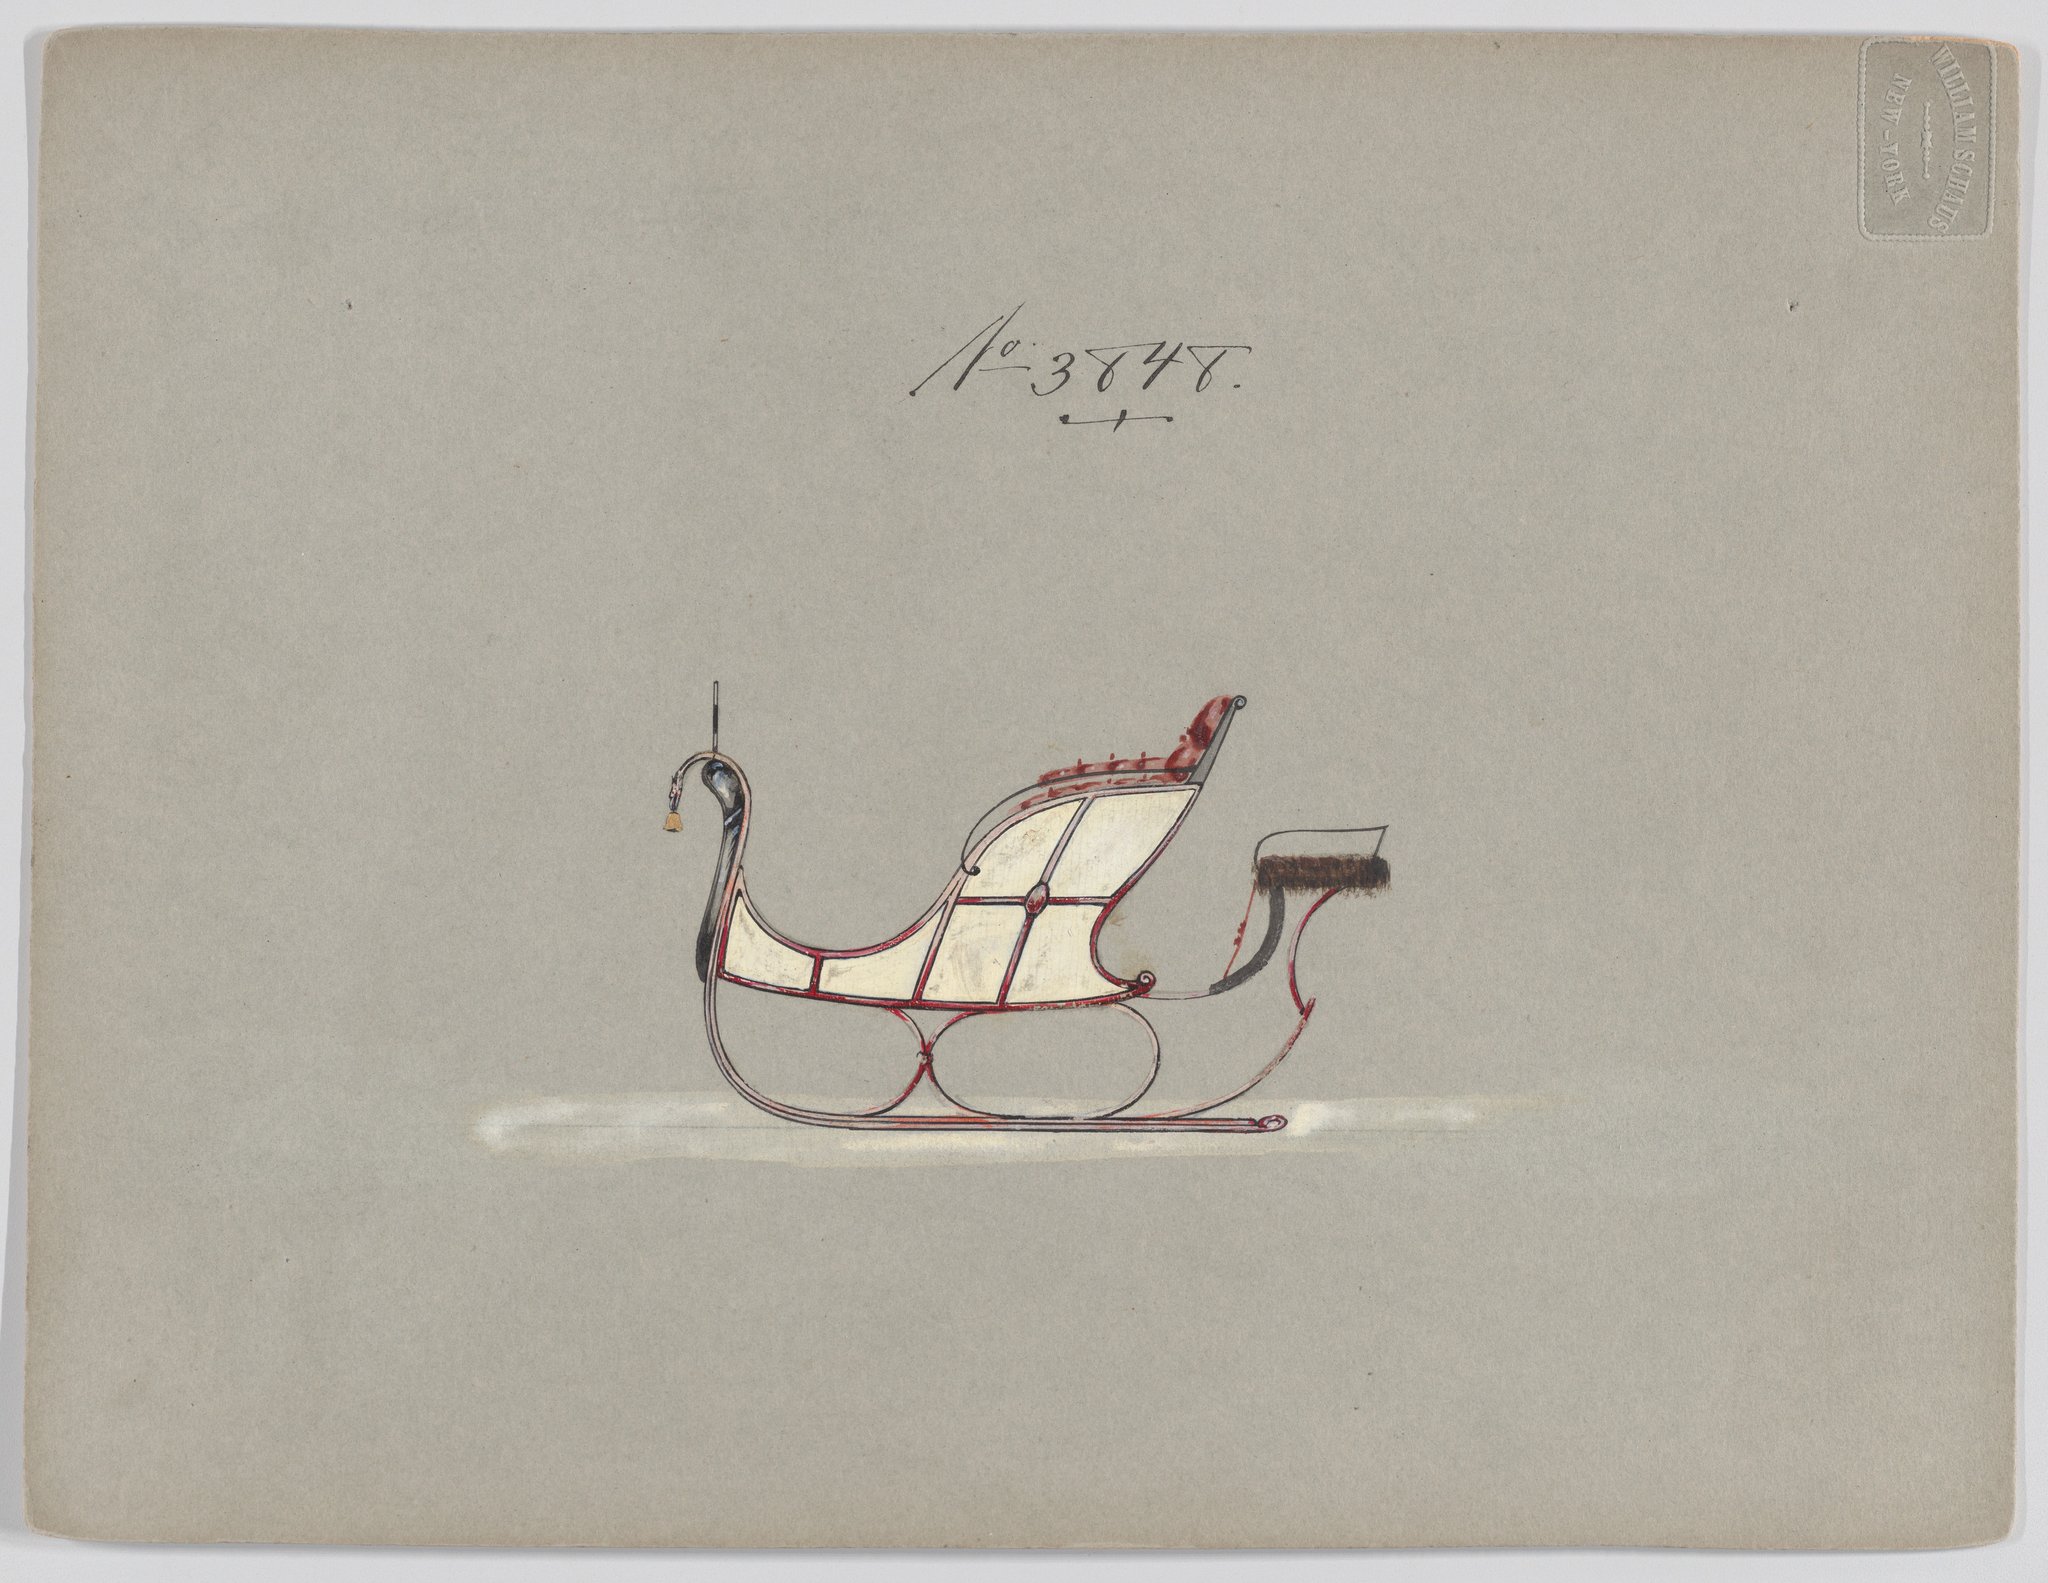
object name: drawing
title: Sleigh with Rumble Seat # 3848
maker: brewster & co.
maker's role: manufacturer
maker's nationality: american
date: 1883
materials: gum arabic, ink, watercolor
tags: sleighs